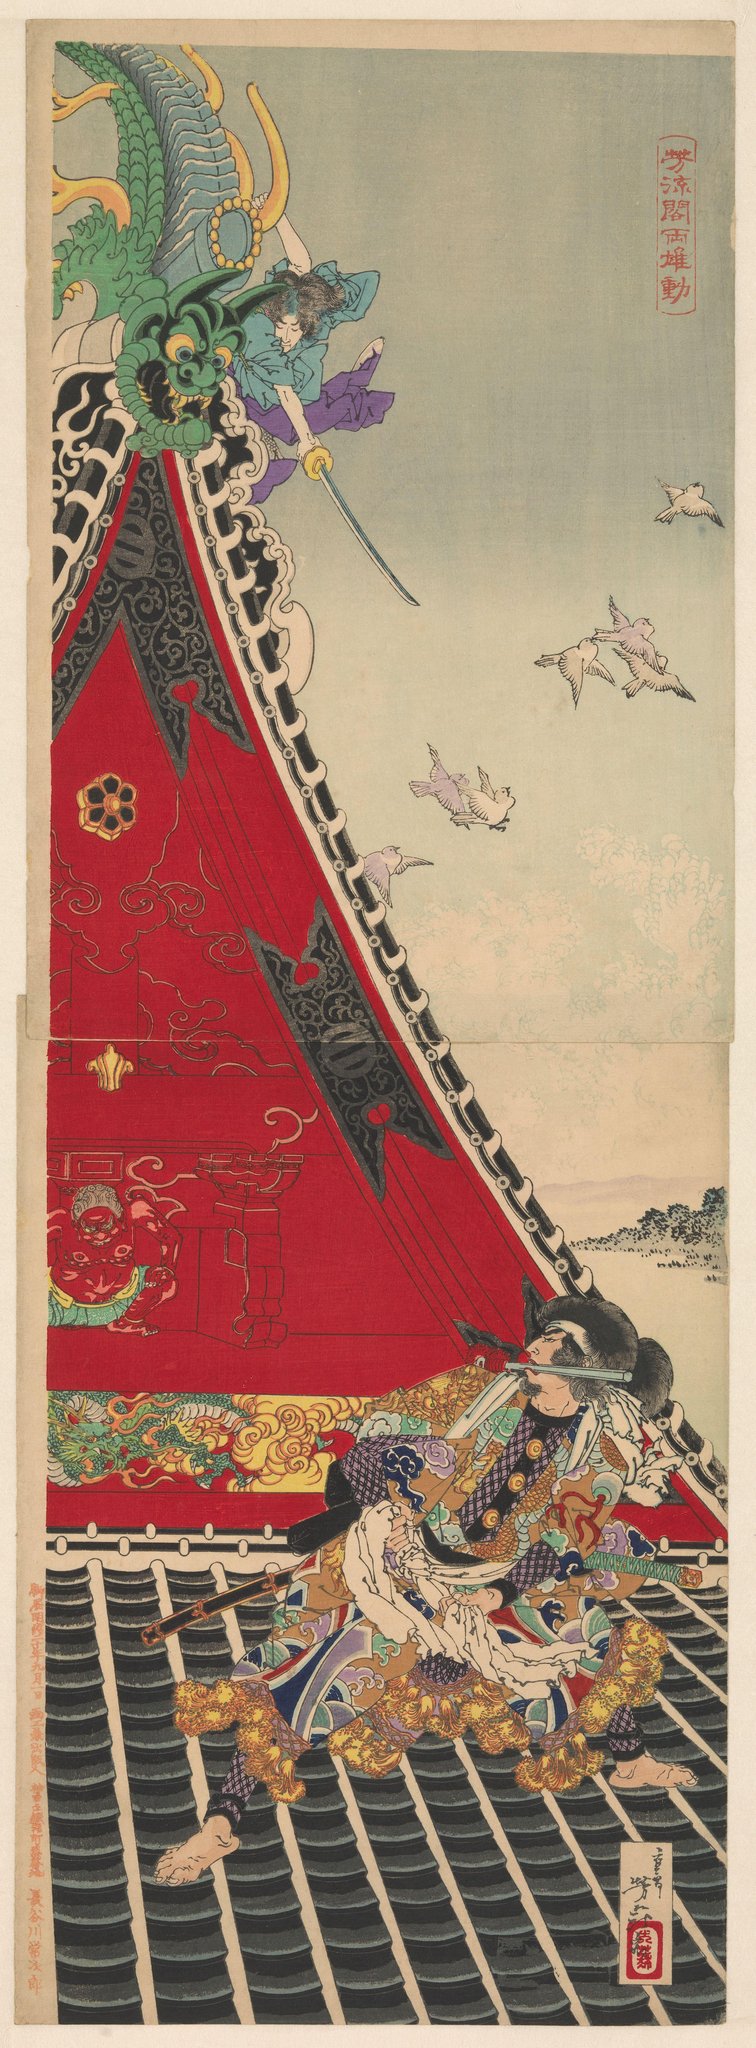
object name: print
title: Fight on the roof between the two rivals Genpachi en Shino on the Hóryûkaku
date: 1887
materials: paper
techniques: woodcut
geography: japan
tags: roof (of house or building), fighting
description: Een gevecht tussen de broers Inuzuka Shino en Inukai Genpachi op het dak van het Hôryûkaku paviljoen. Deze prent verbeeldt een deel uit het verhaal 'De avonturen van de acht honden van Satomi' (Nansô Satomi hakkenden), geschreven tussen 1814-41 door Takizawa Bakin. Het vertelt over de acht broers die prinses Fuse als moeder en een hond als vader hadden. Na elkaar uit het oog verloren te zijn en vele avonturen en gevechten later, herkennen ze elkaar weer aan hun tatoeage. (verticaal diptiek)